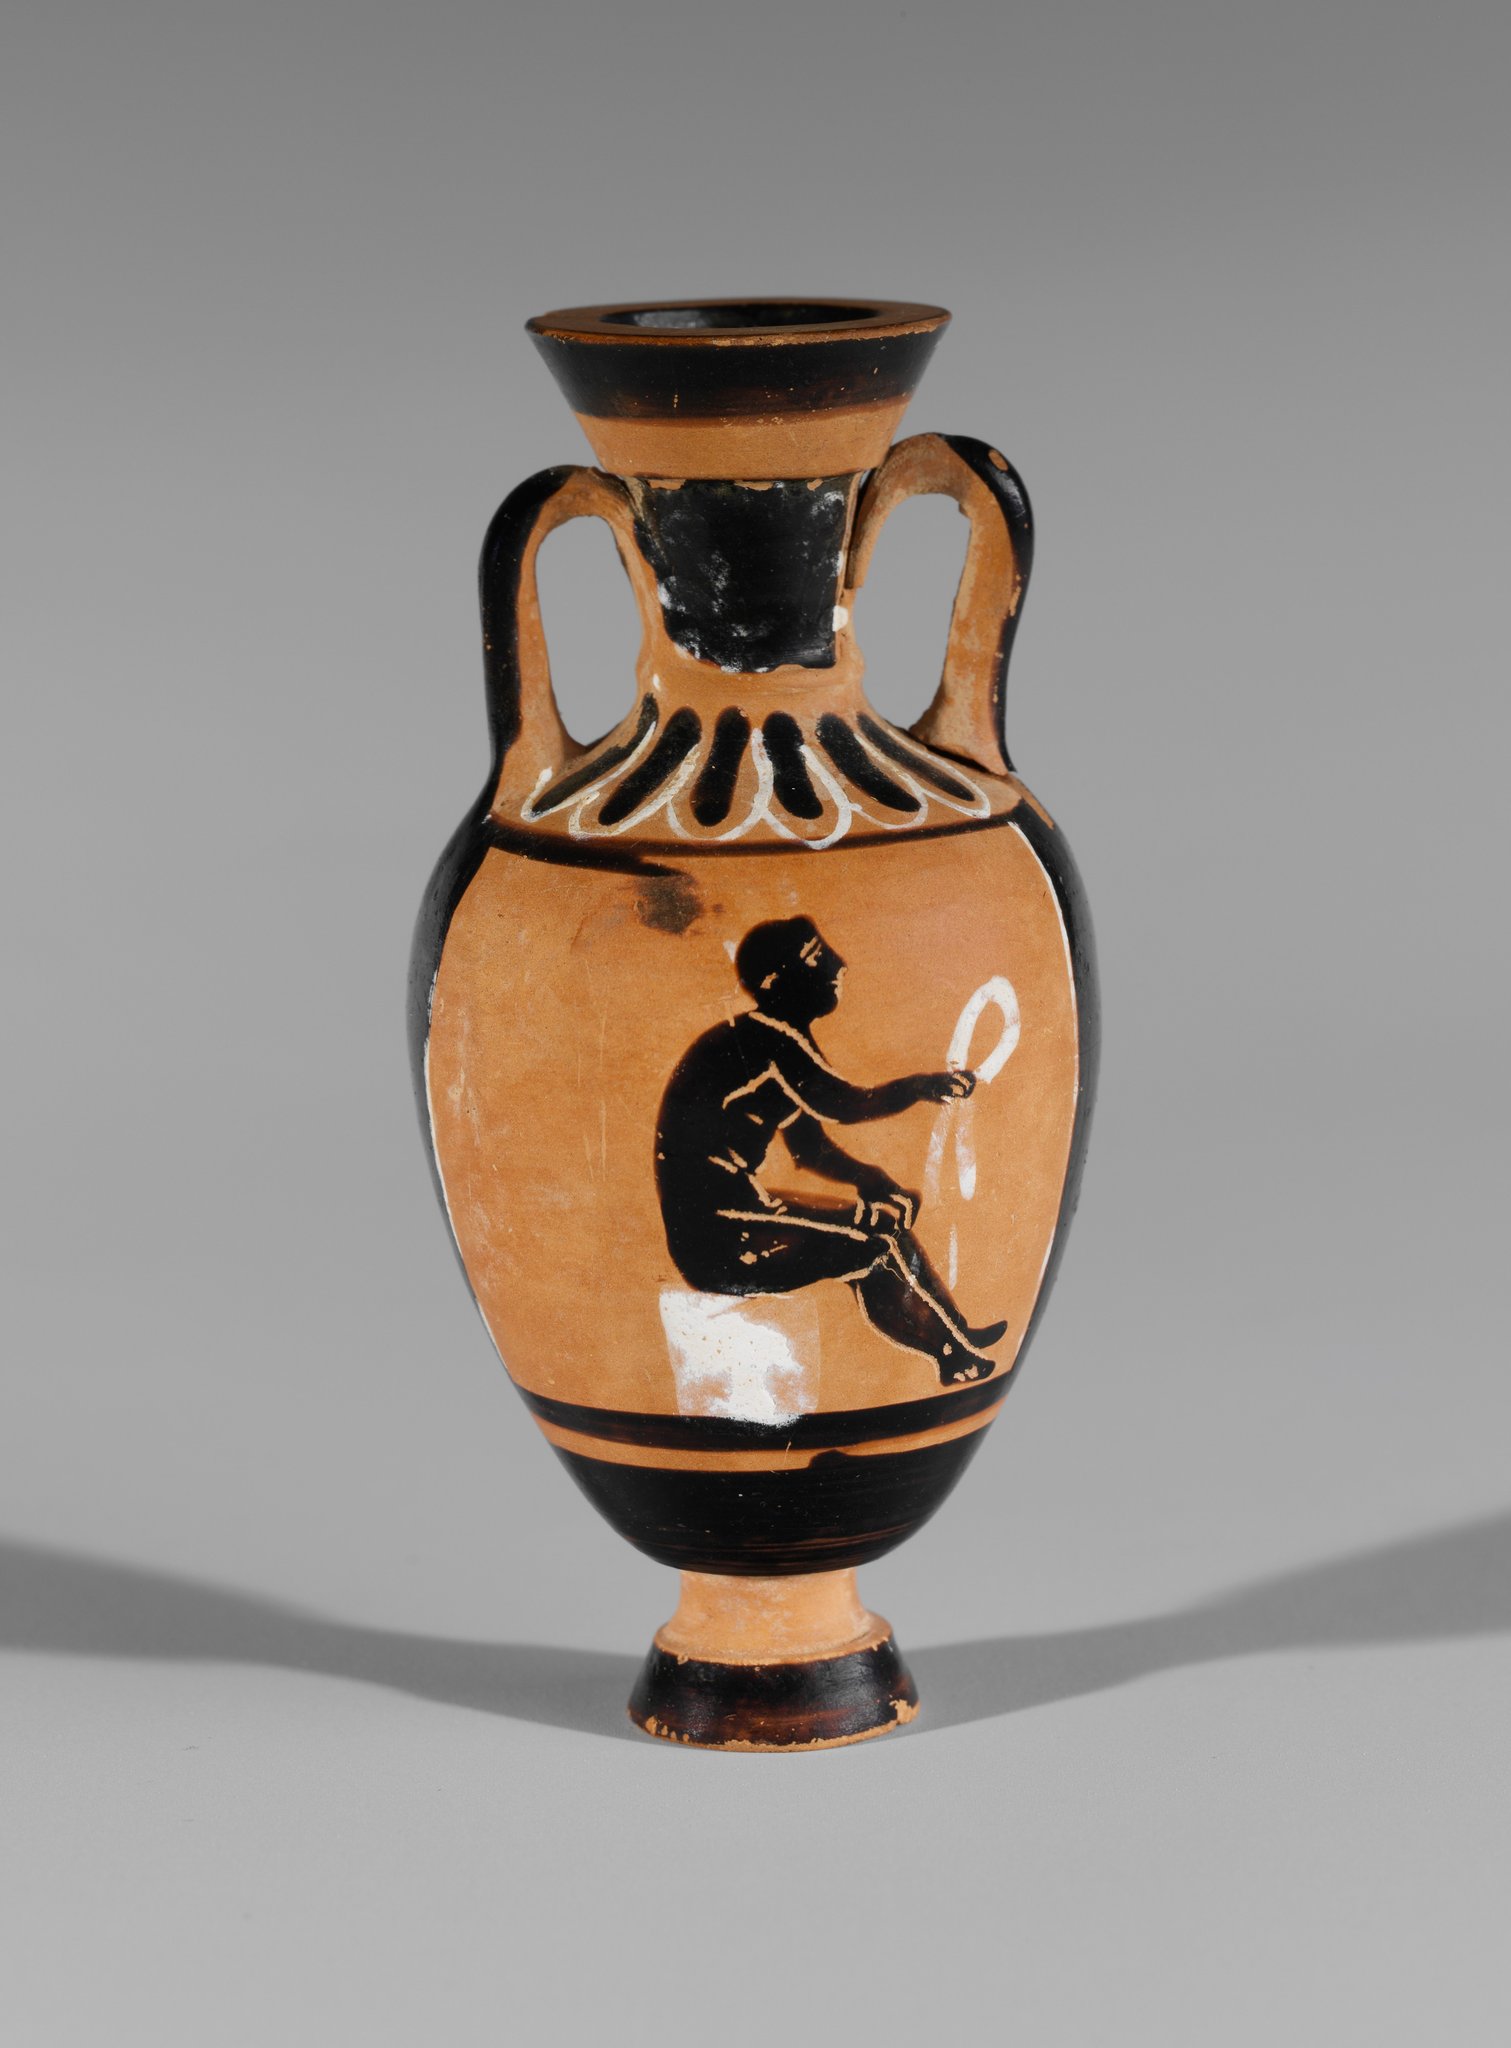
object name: panathenaic amphora, miniature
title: Terracotta miniature Panathenaic amphora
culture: greek, attic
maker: bulas group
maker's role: artist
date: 400 BCE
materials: terracotta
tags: men,athena,athletes